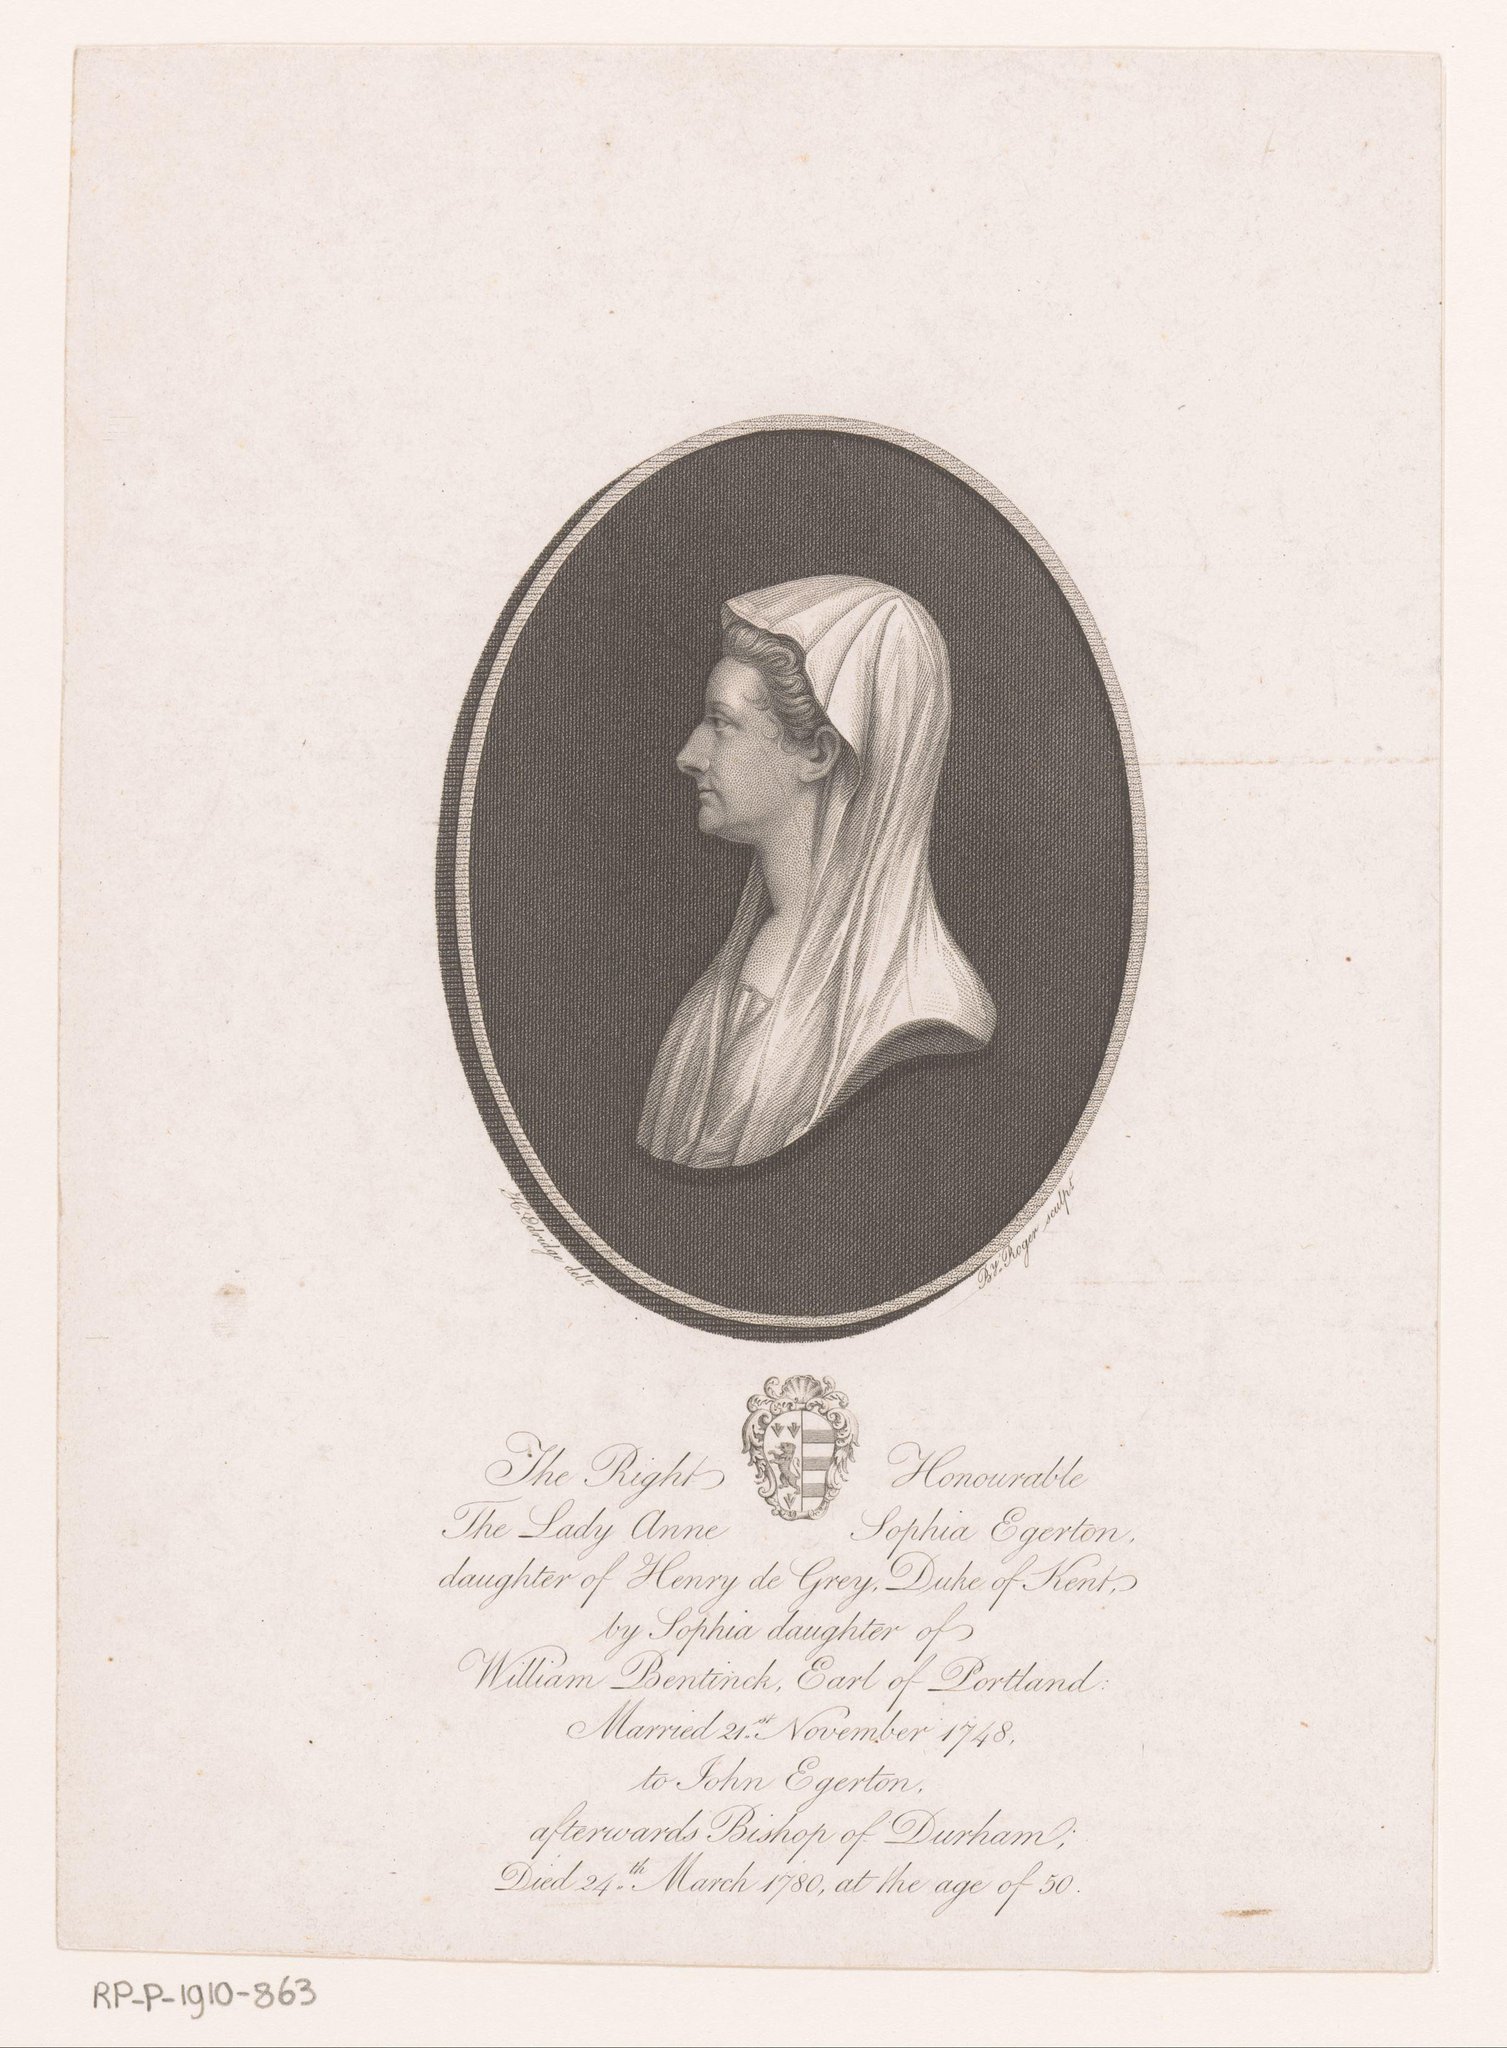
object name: print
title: Portret van Anne Sophia Egerton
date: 1780-1840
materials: paper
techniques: etching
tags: historical persons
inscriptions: collector's mark: Lugt 2228